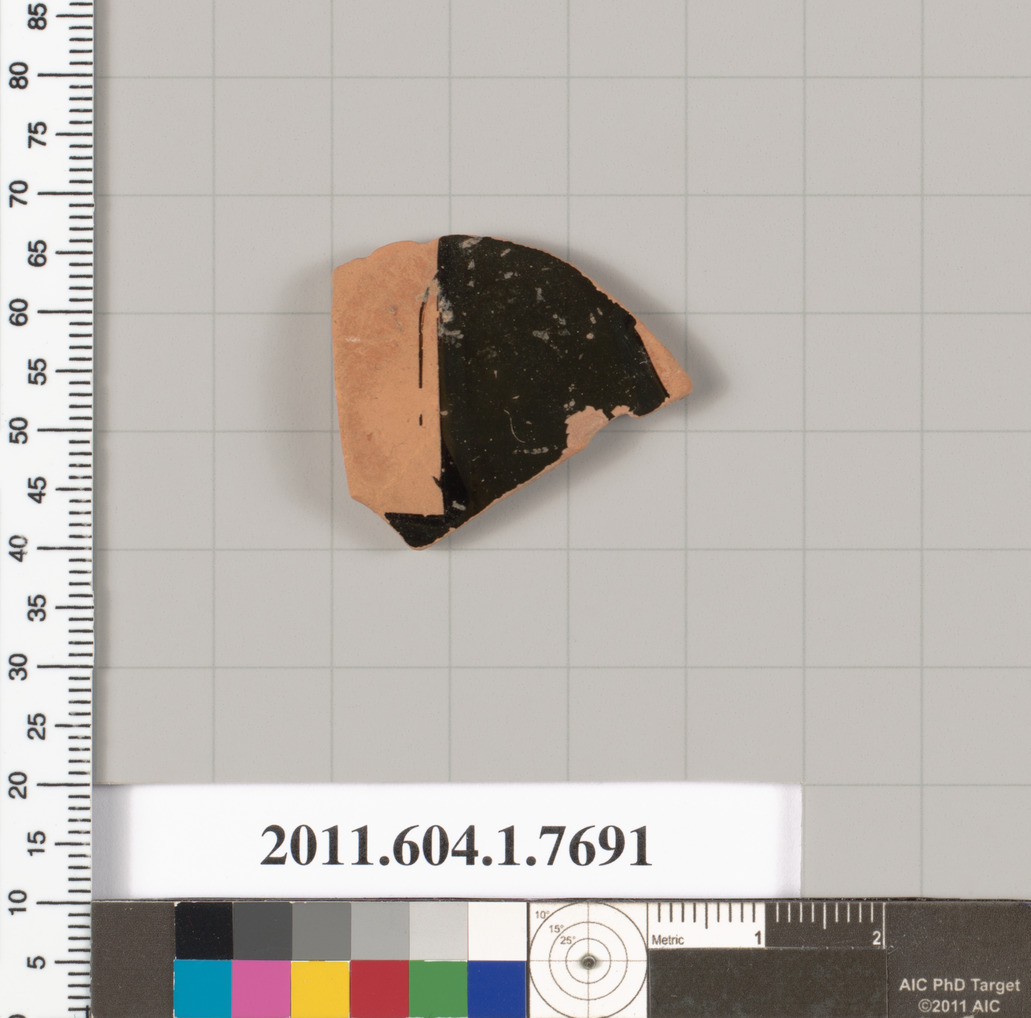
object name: kylix fragment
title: Terracotta fragment of a kylix (drinking cup)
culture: greek, attic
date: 460-450 BCE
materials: terracotta